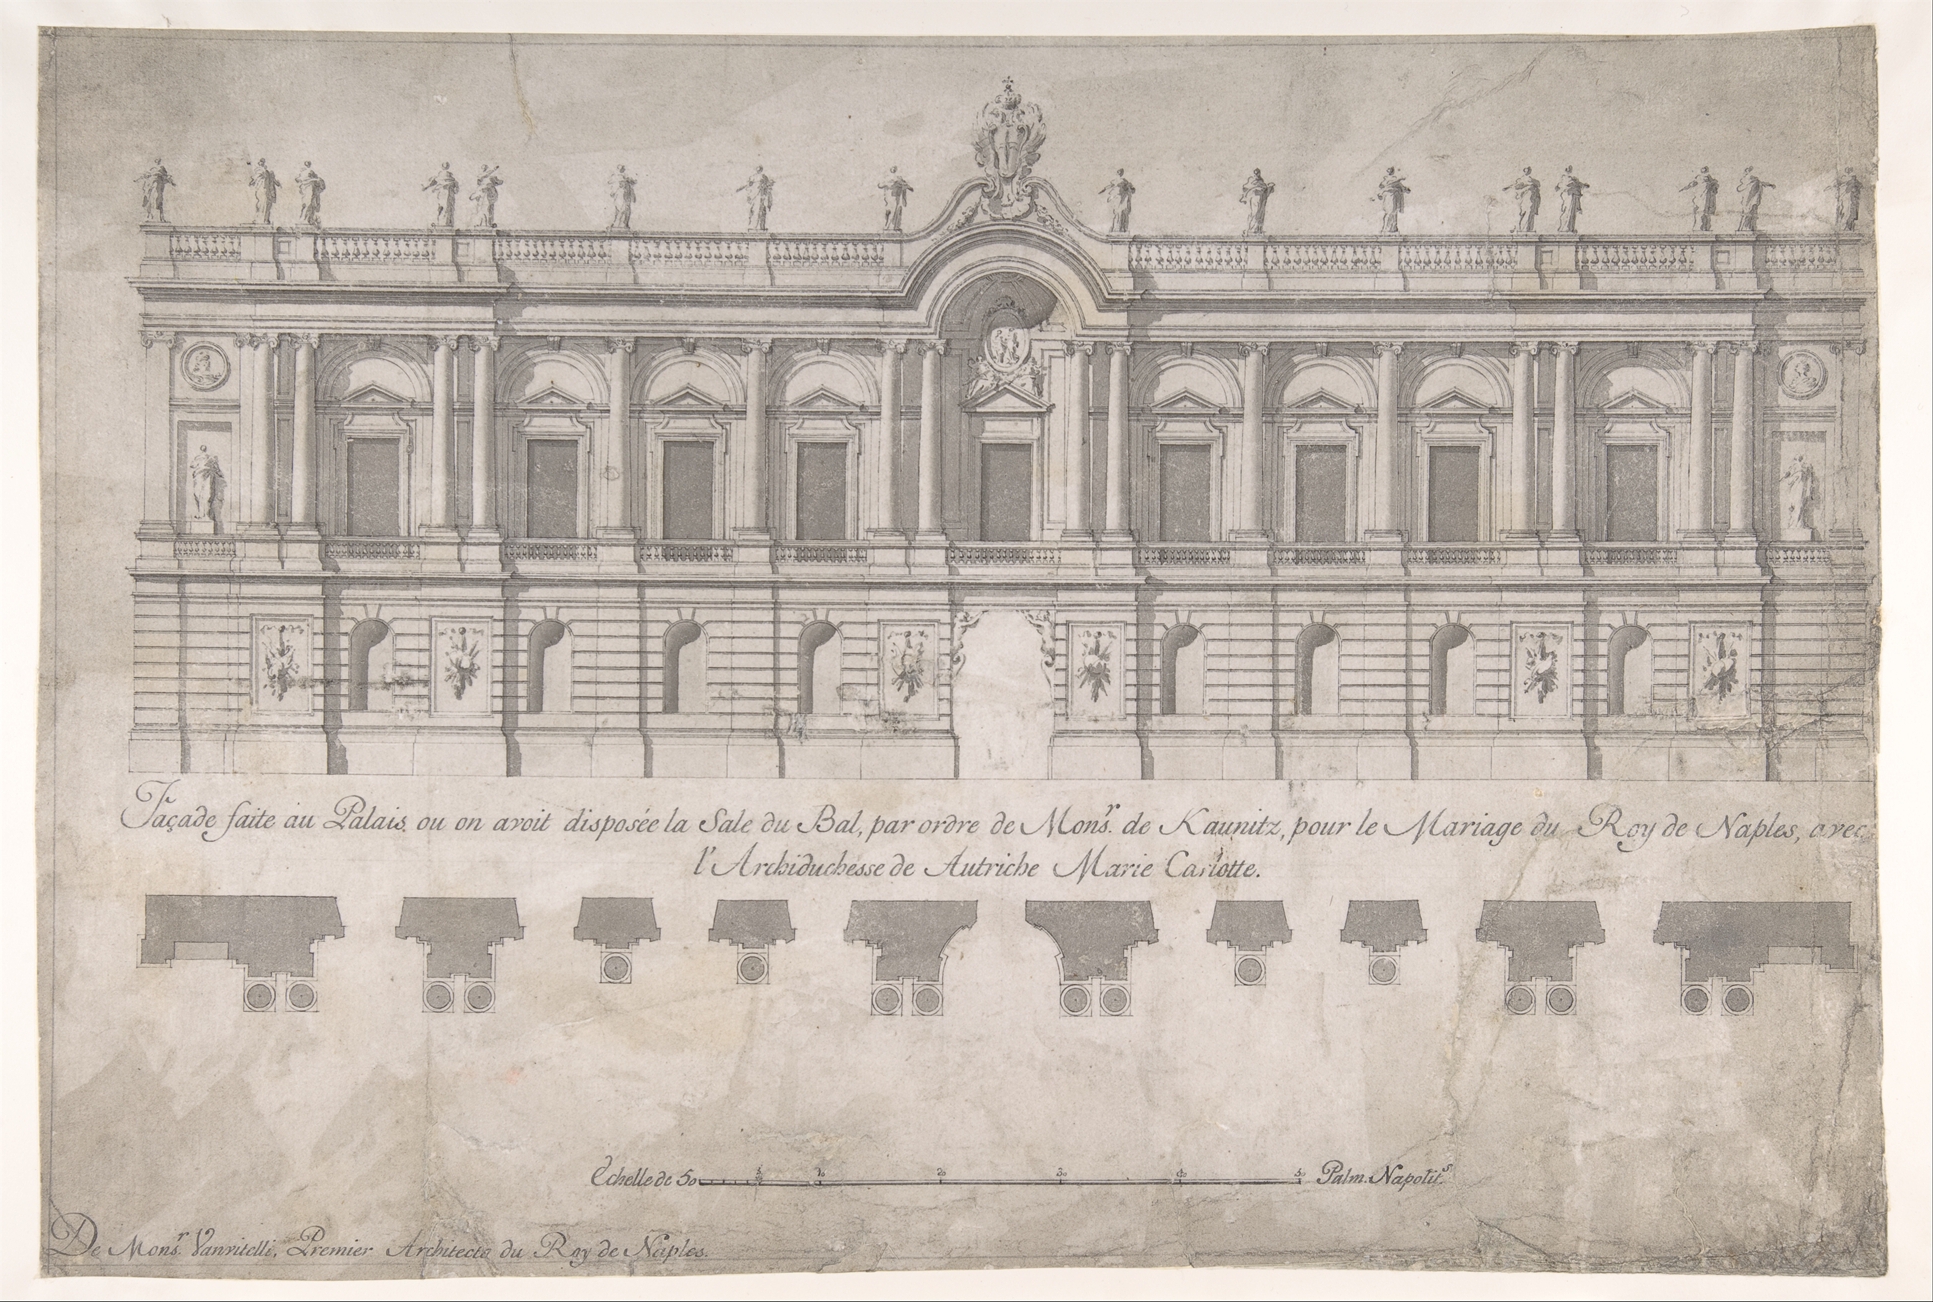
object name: drawing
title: Façade of Palace decorated for the Marriage of the King of Naples to the Archduchess of Austria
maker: luigi vanvitelli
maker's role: artist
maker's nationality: italian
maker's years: 1700-1773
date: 1700-1773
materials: graphite, ink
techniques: brush, pen, drawing, wash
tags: architecture,palaces